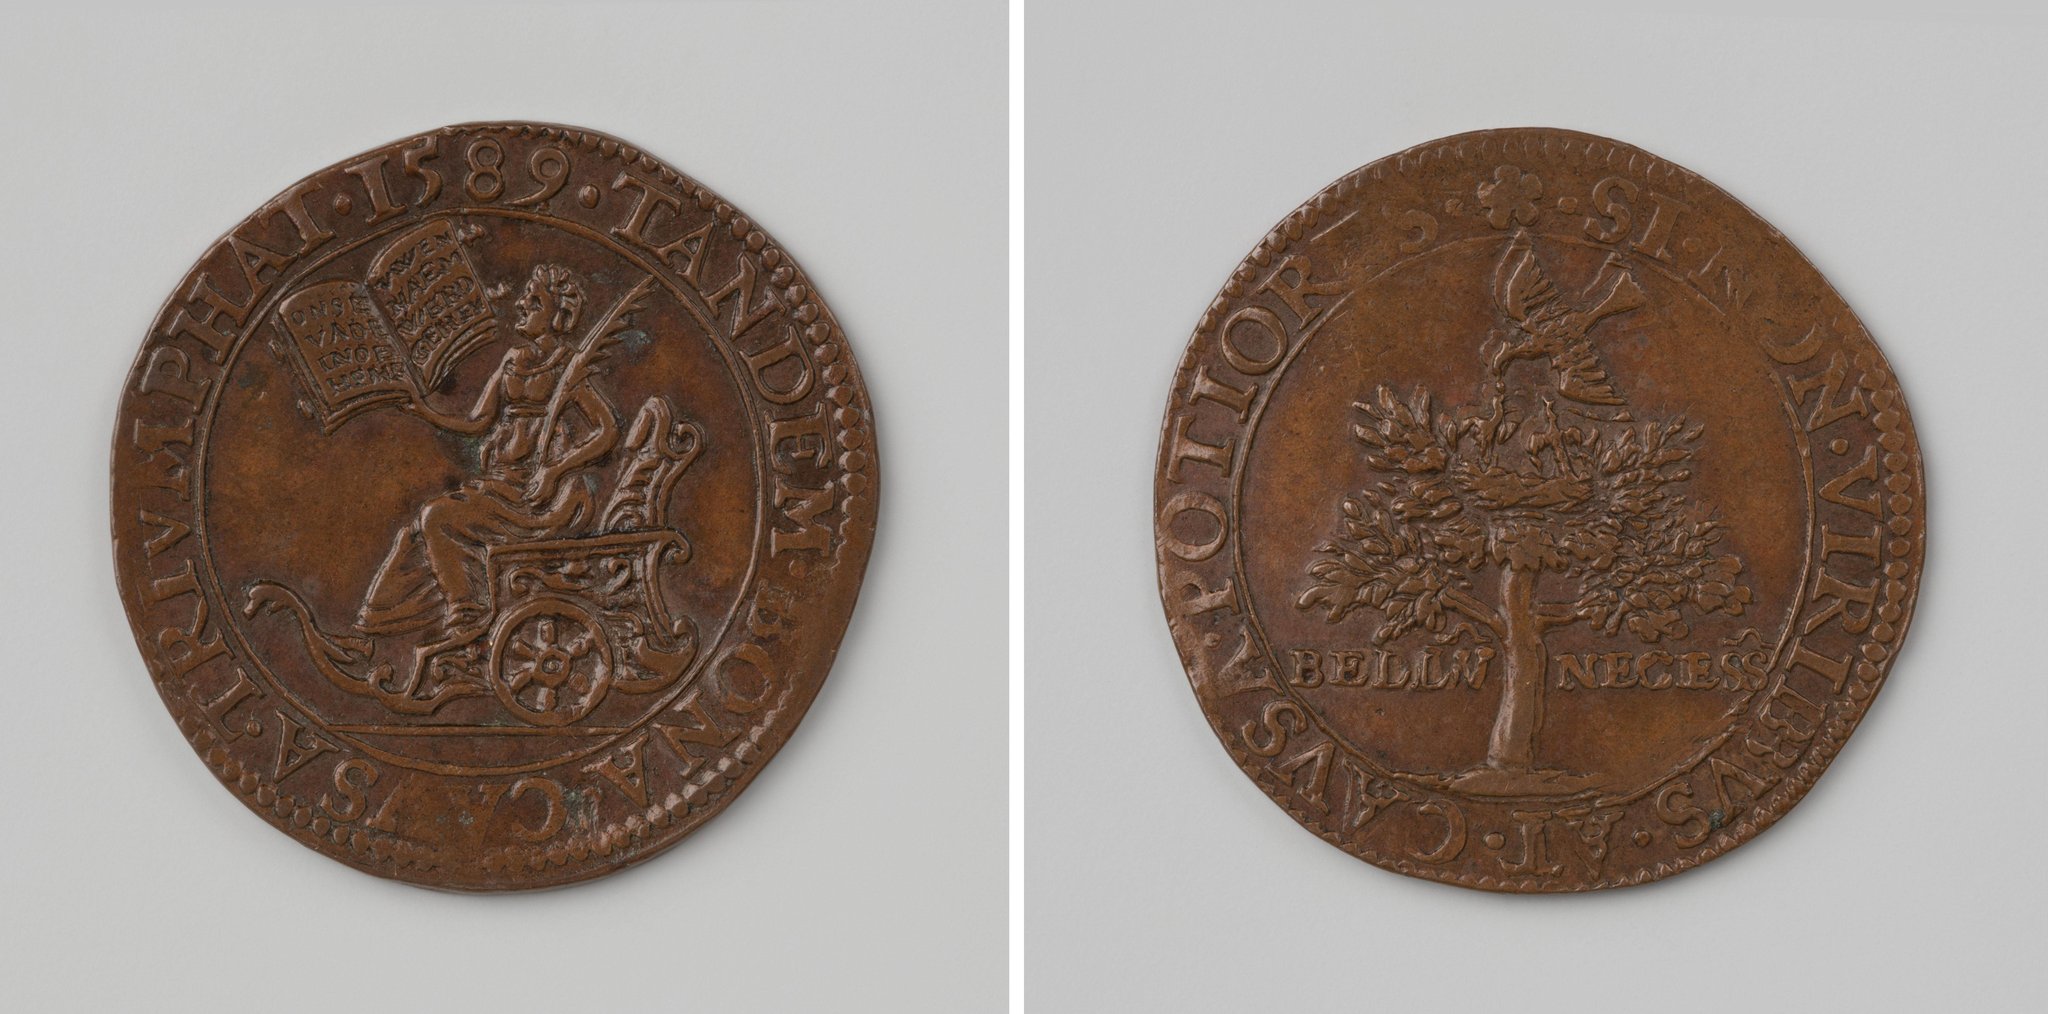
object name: jeton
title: Dankdag op het vergaan van de Spaanse armada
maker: Anonymous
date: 1589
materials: copper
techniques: striking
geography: dordrecht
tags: tachtigjarige oorlog, vergaan van de spaanse armada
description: Koperen penning. Voorzijde: vrouw met geopend boek met opschrift in rechter- en palmtak in linkerhand, zittend in zegekar binnen omschrift. Keerzijde: nest met twee kleine vogels in boom, die zich gezamelijk verdedigen tegen grote vogel tussen opschrift binnen omschrift